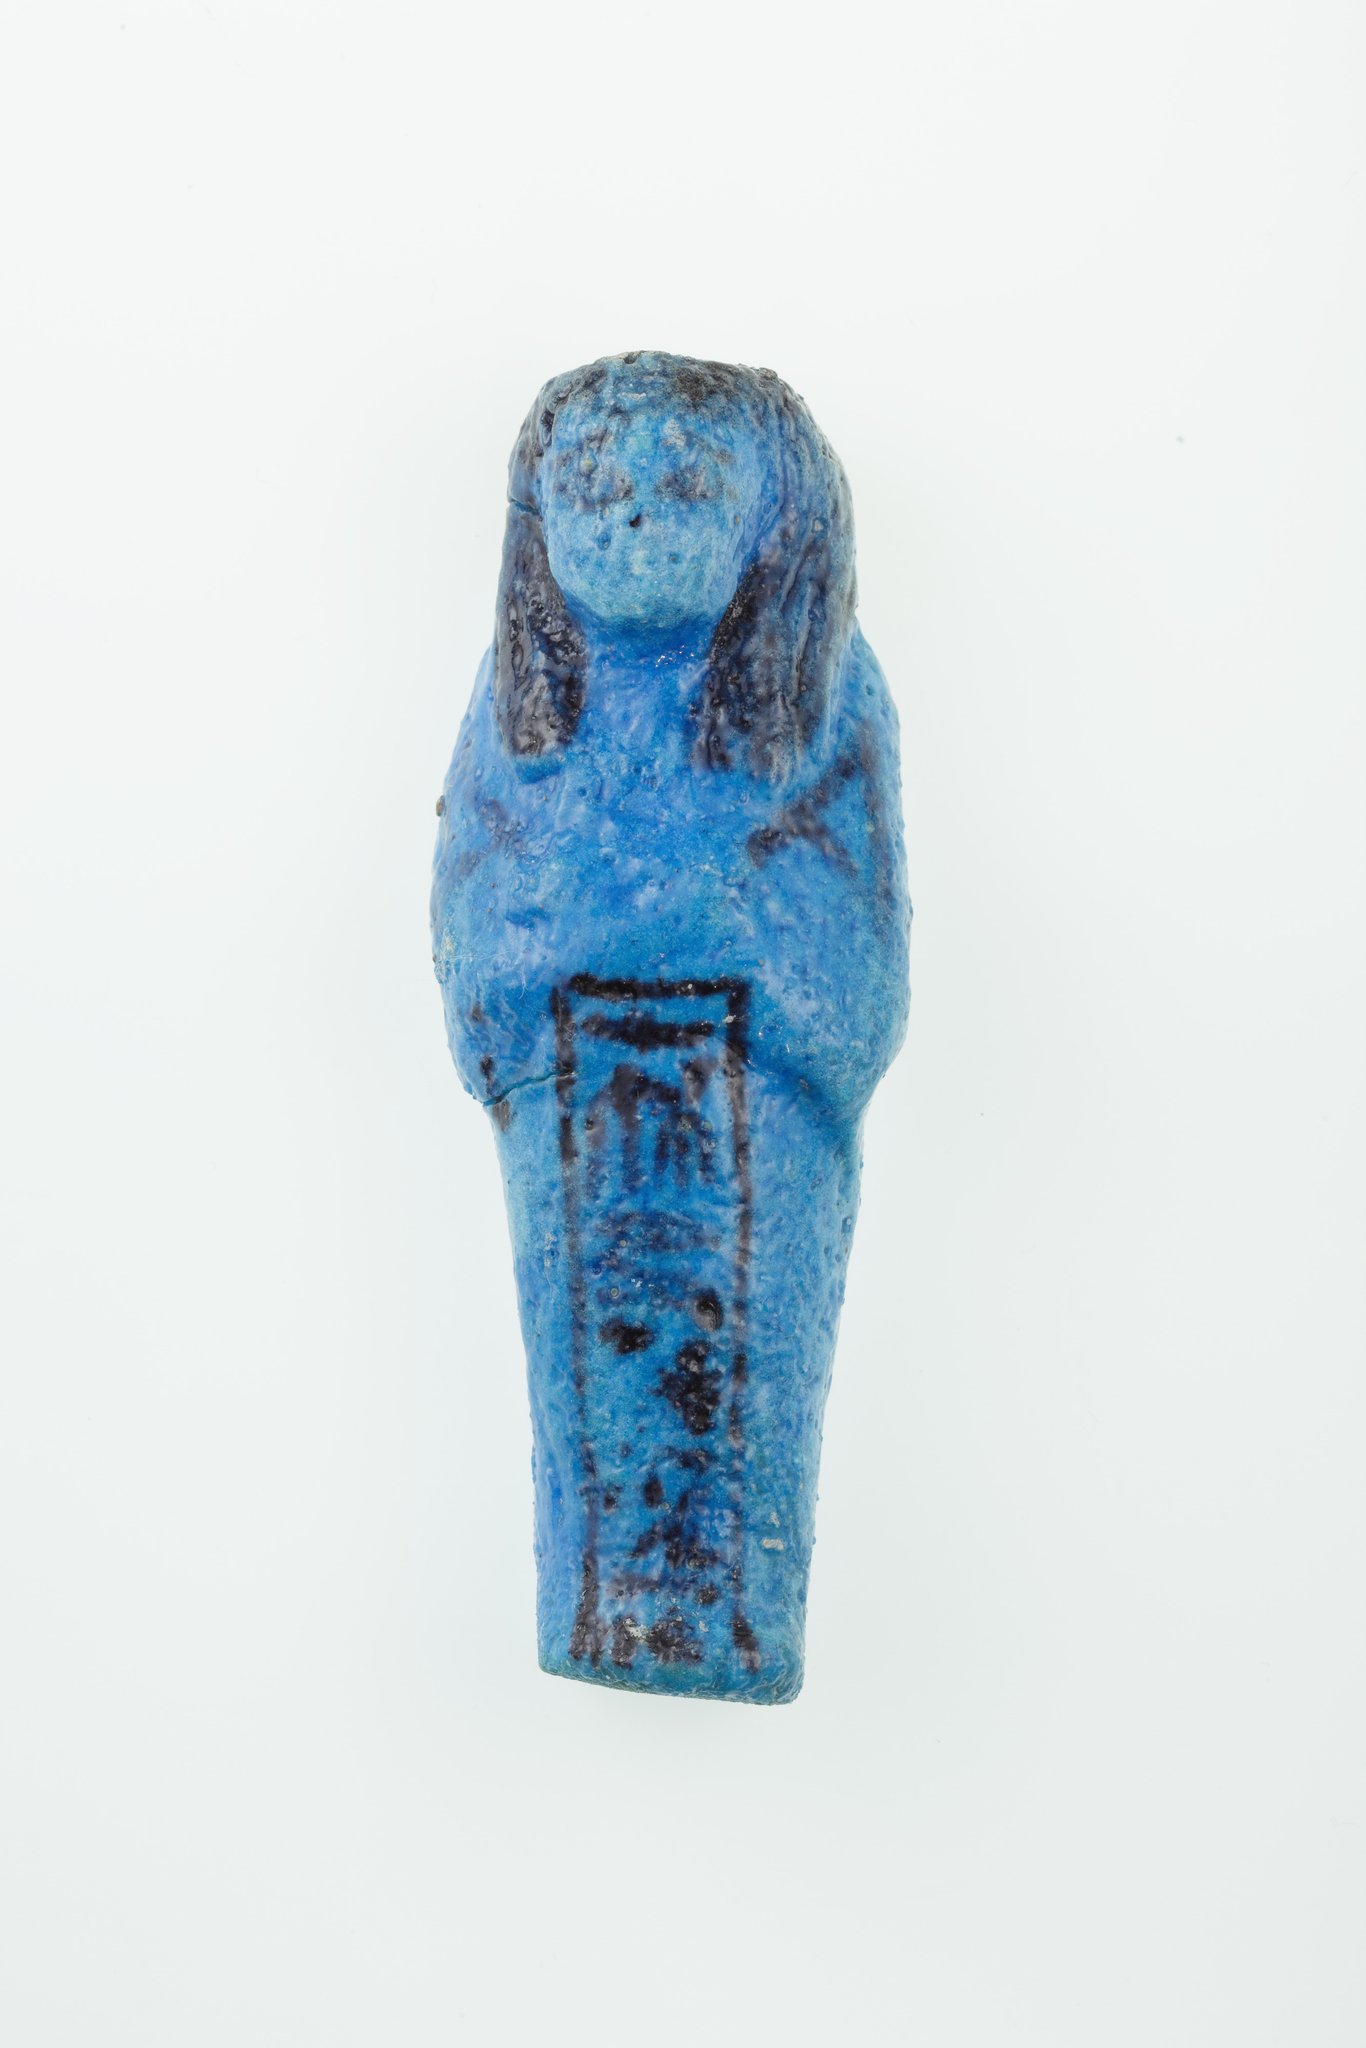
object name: shabti, nauny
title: Worker Shabti of Nauny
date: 1050 BCE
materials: faience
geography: egypt